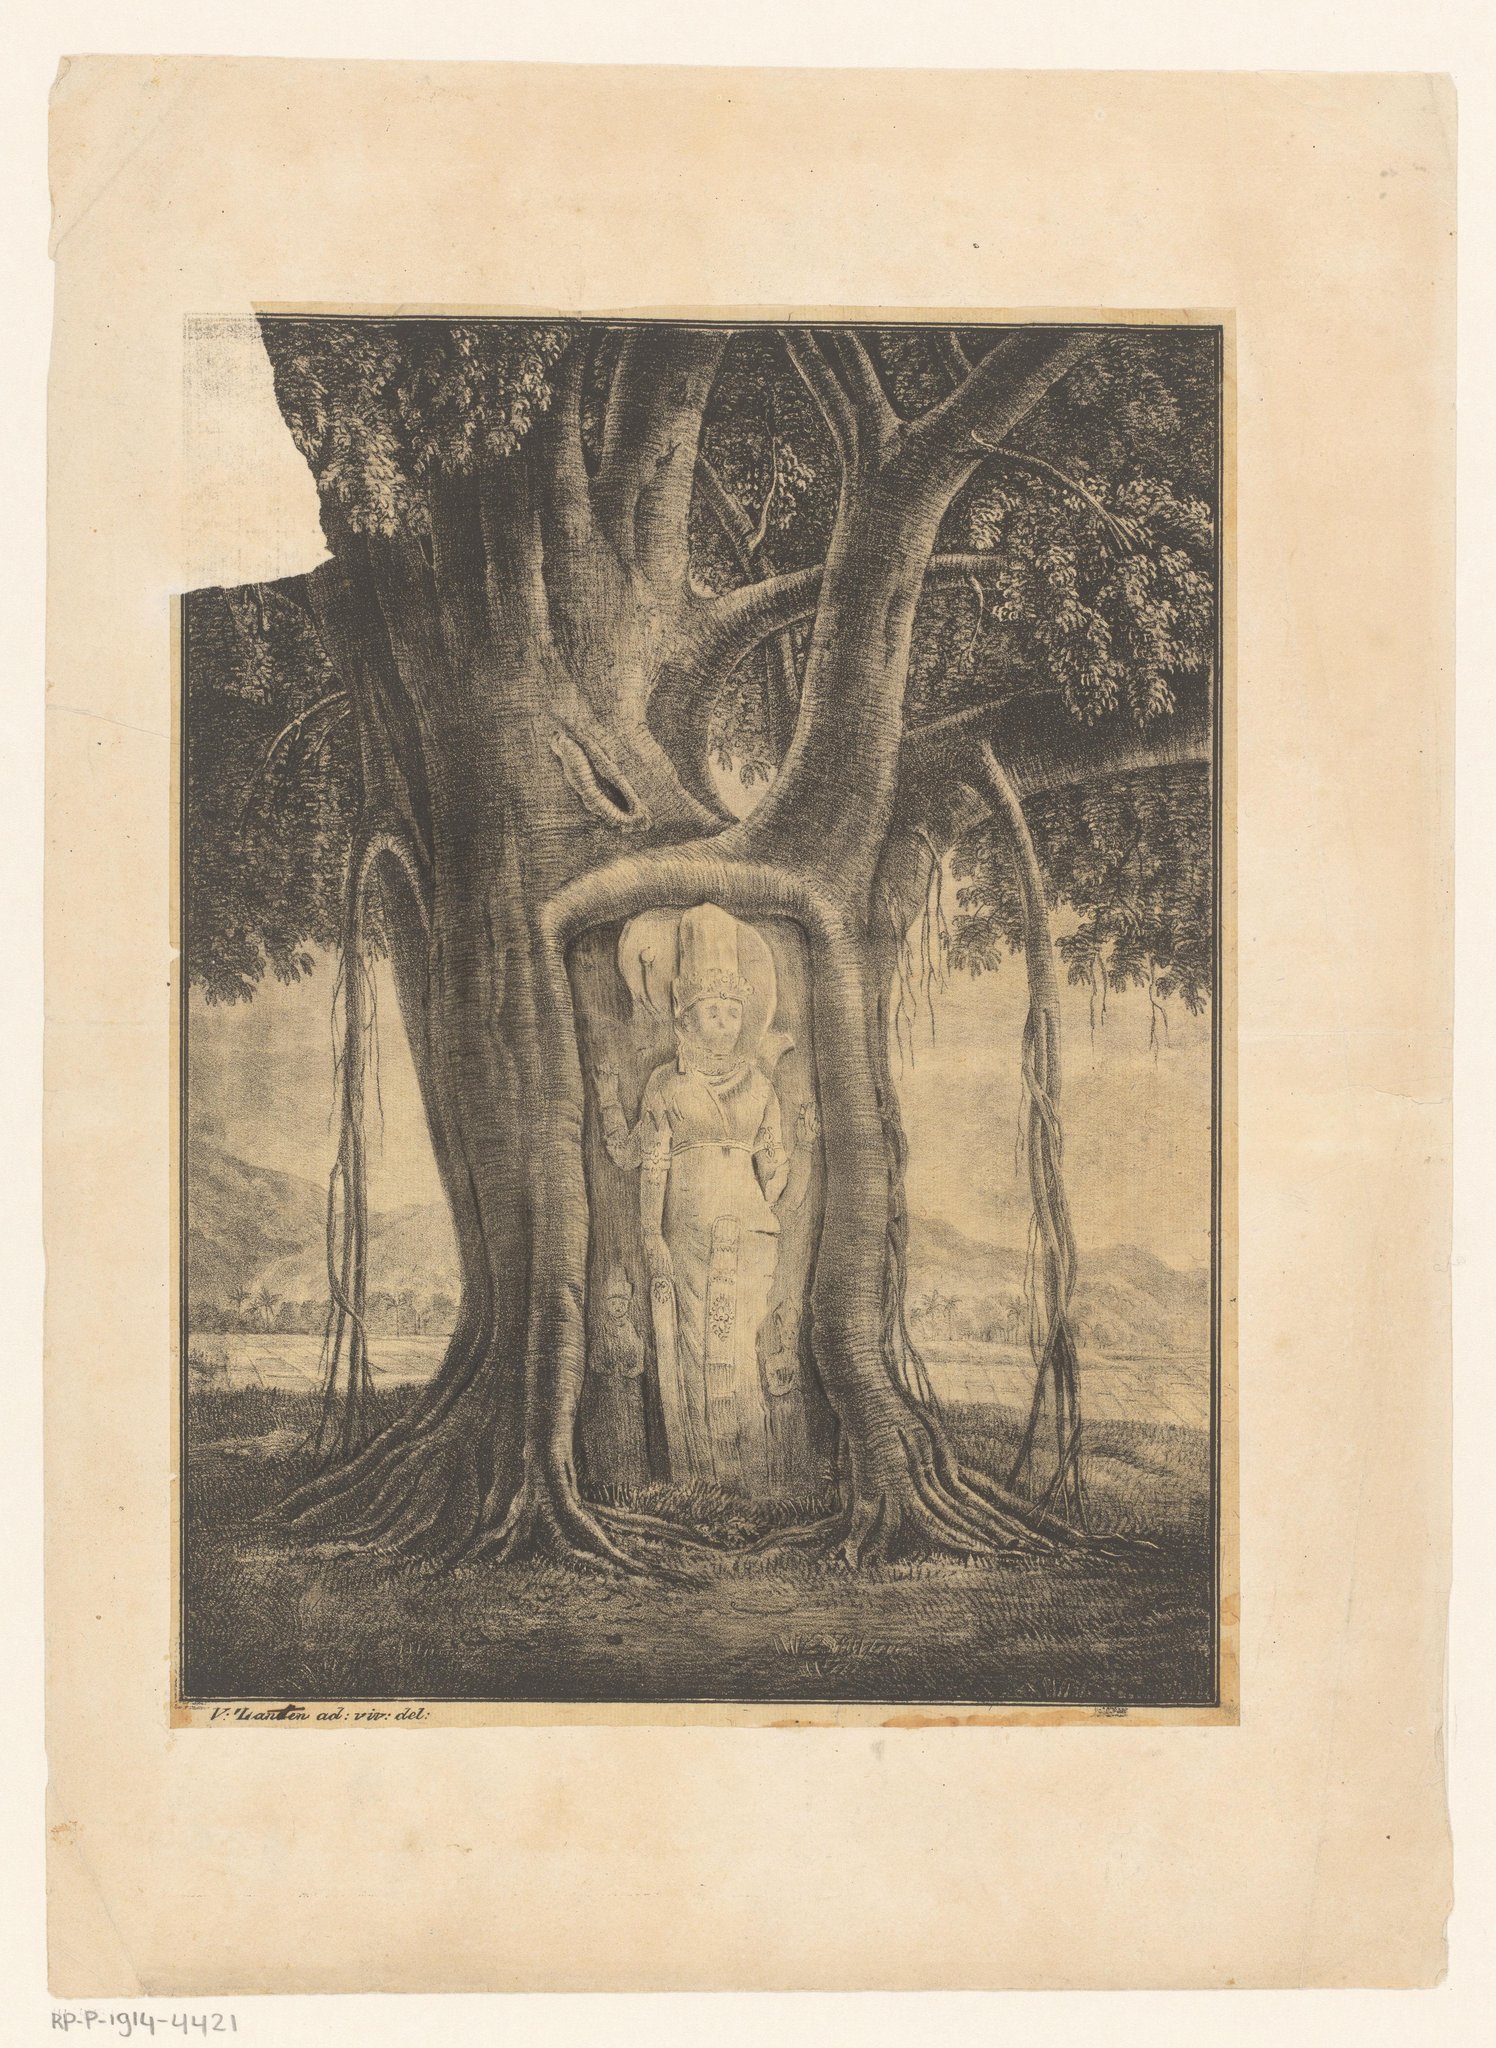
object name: print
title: Altaar met drie goden uitgesneden in een boom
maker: v. lanten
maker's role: print maker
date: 1800-1900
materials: paper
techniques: lithograph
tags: trees, hinduism, buddhism, jainism, altar ~ non-christian religions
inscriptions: collector's mark: Lugt 2228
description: Grote figuur en twee kleinere, mogelijk afkomstig uit de Indonesische mythologie. Deze kenmerkt zich door invloeden van verschillende legenden en religies, waaronder animisme. In de negentiende eeuw kwamen dergelijke altaren in de natuur veel voor. De invloed van het hindoeïsme is hier te zien aan de stand van de armen van de figuur.